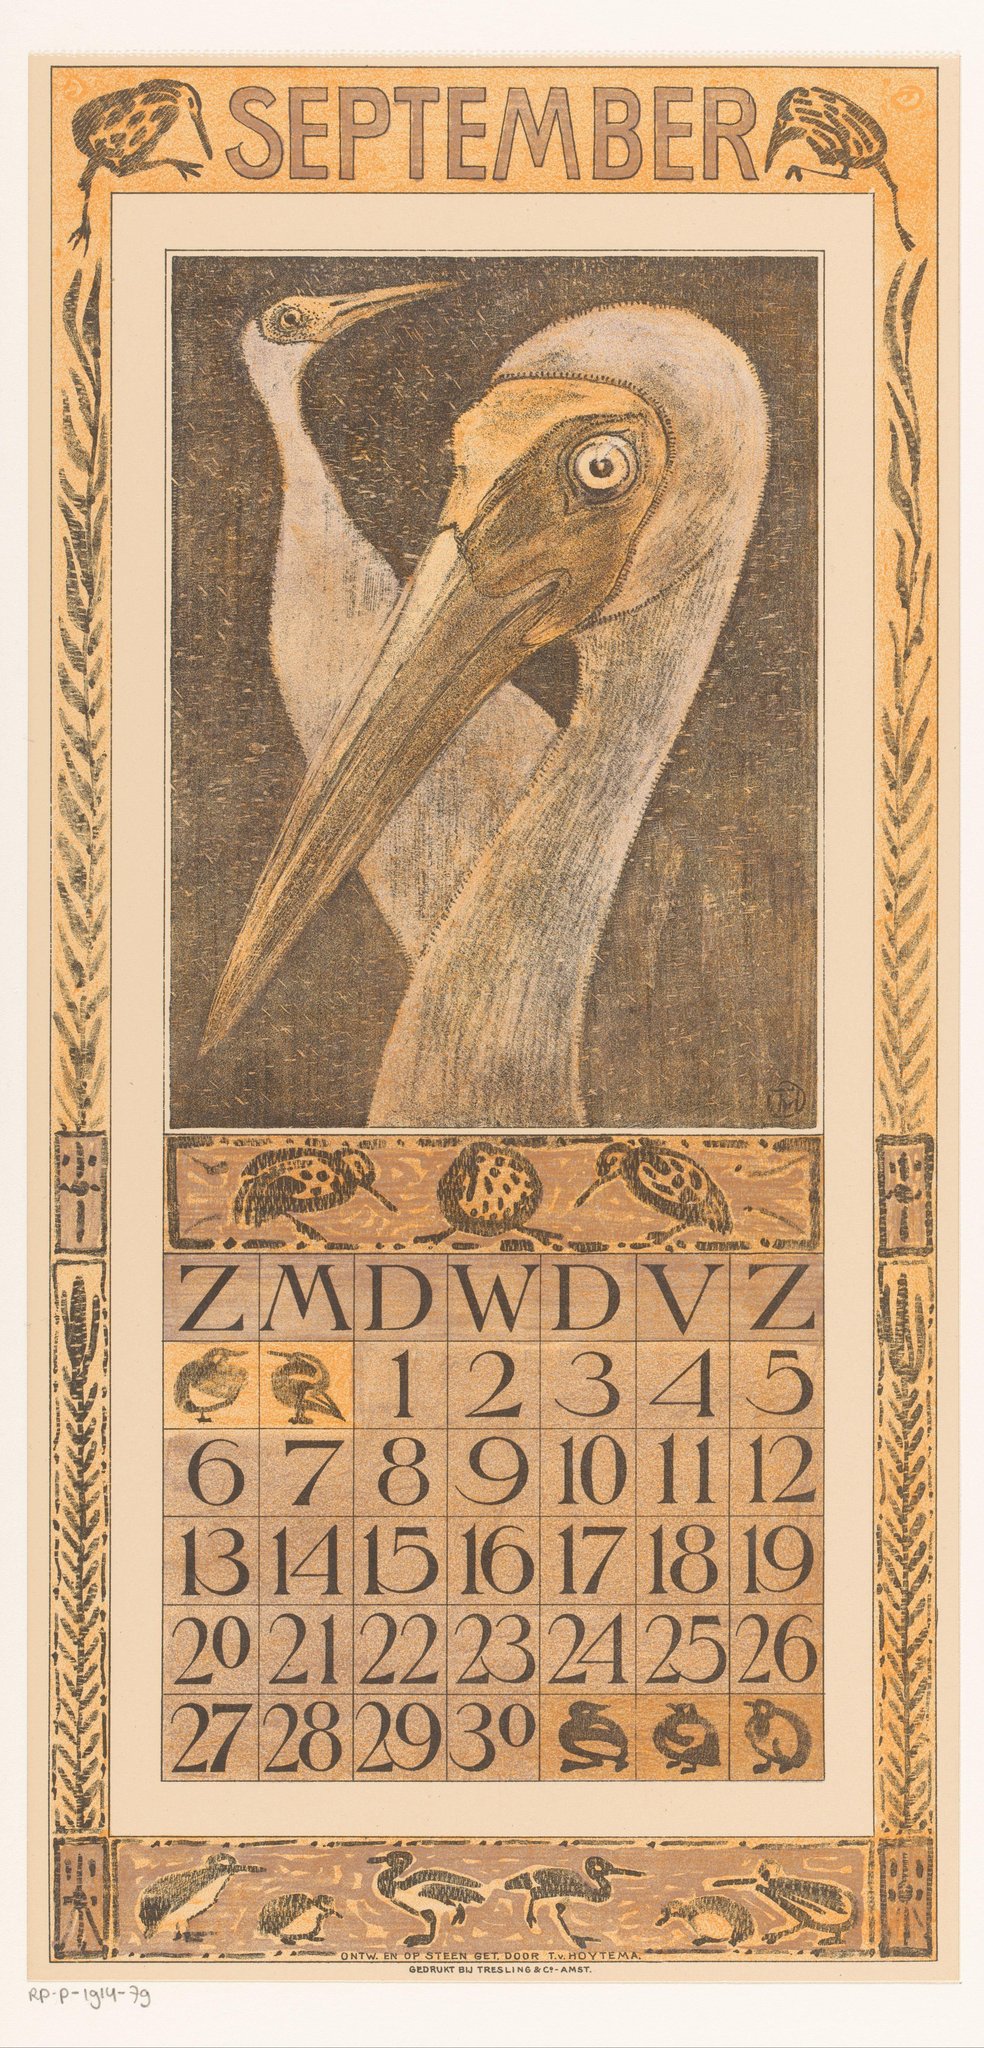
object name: calendar leaf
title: Kalenderblad september met twee vogels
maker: theo van hoytema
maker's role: draughtsman, painter, print maker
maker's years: 1863-1917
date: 1907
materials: paper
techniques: lithograph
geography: amsterdam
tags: walker and runner birds, september ~ other concepts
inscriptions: collector's mark: Lugt 2228